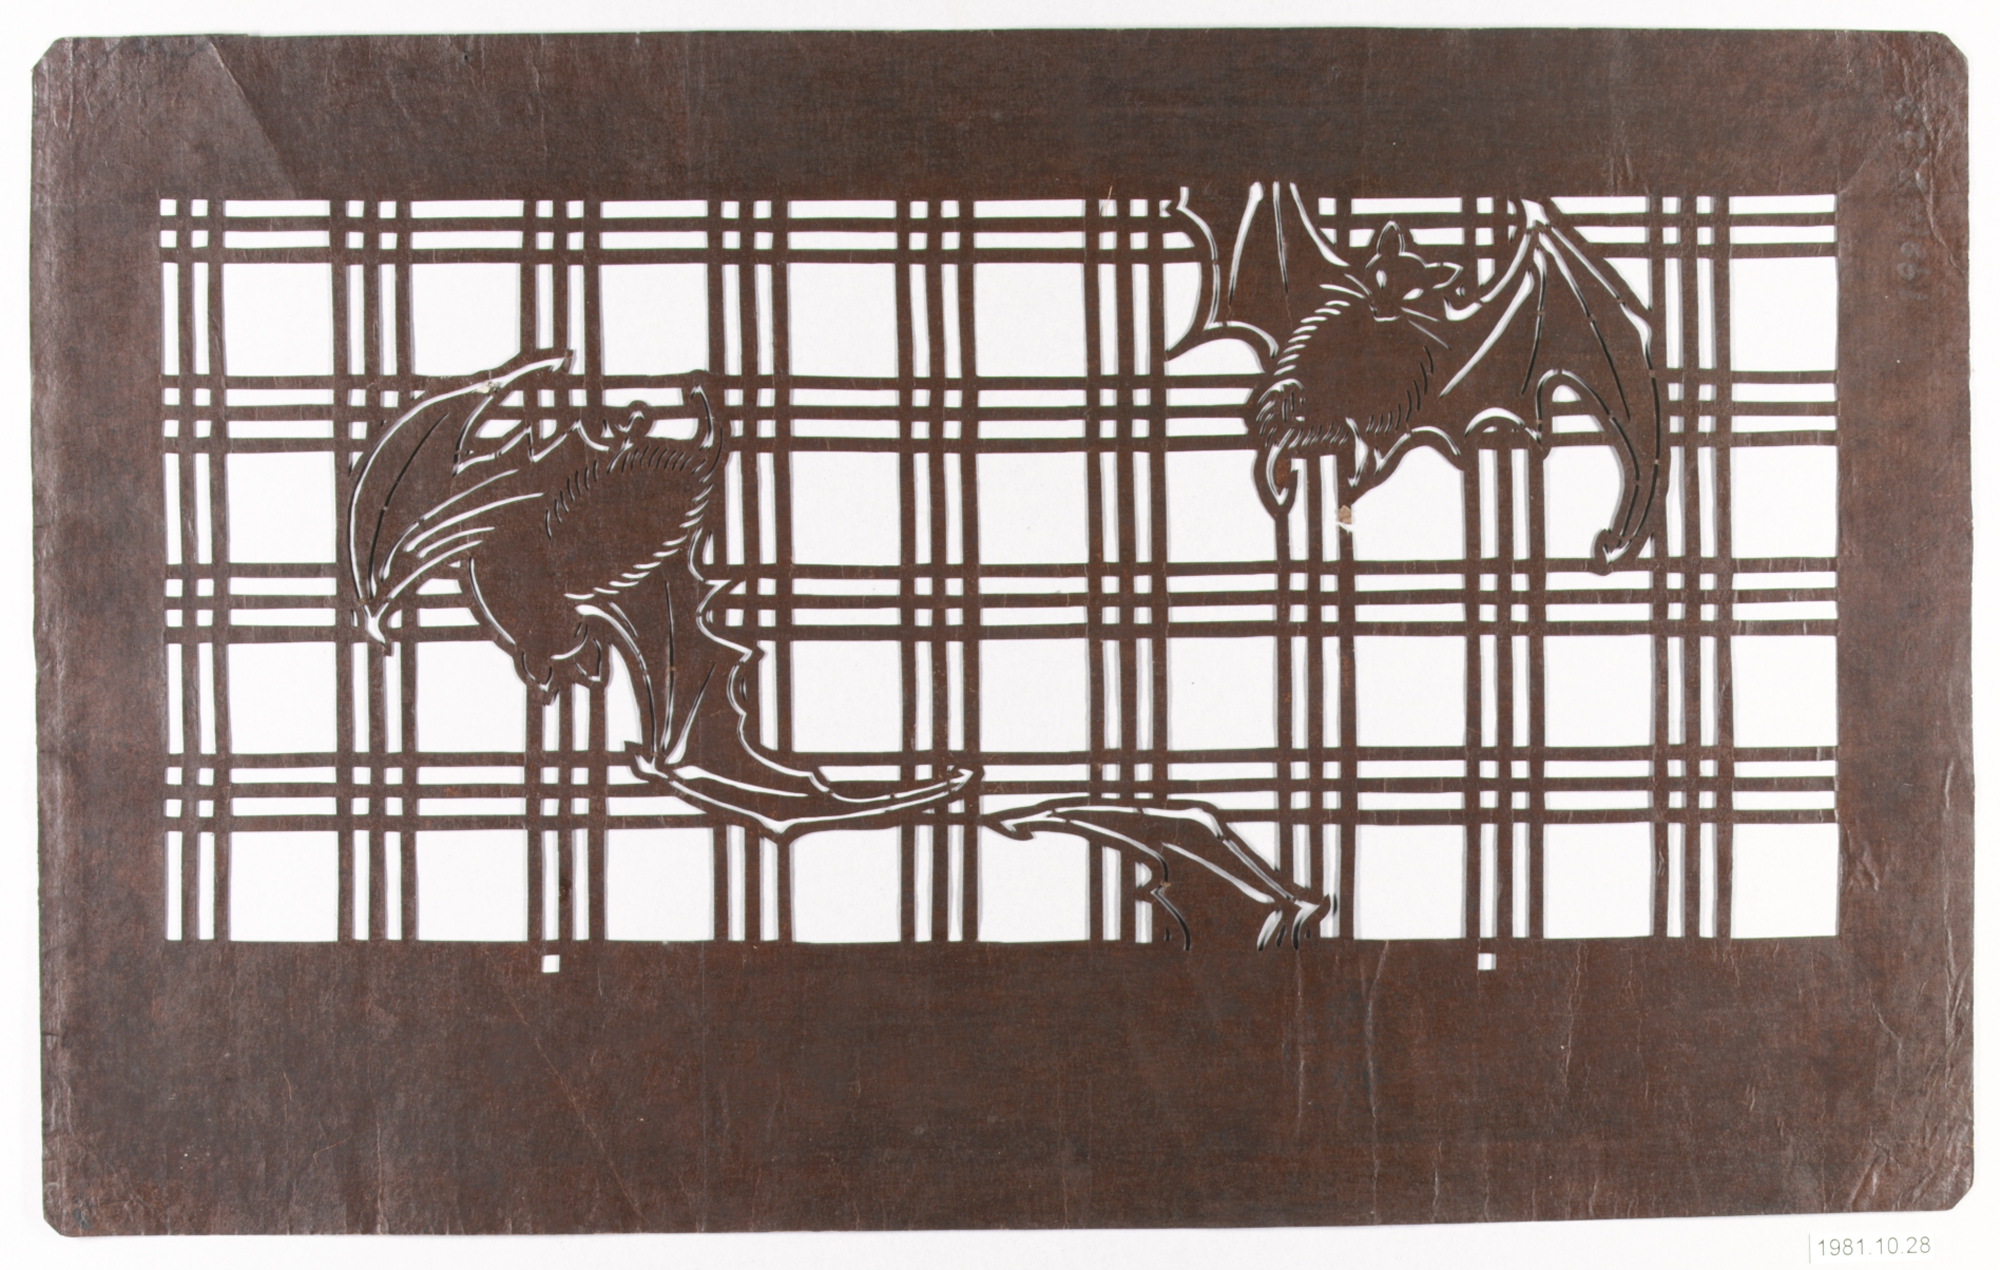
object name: stencil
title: Stencil with Bats on a Lattice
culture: japanese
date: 1801-1900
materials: paper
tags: bats